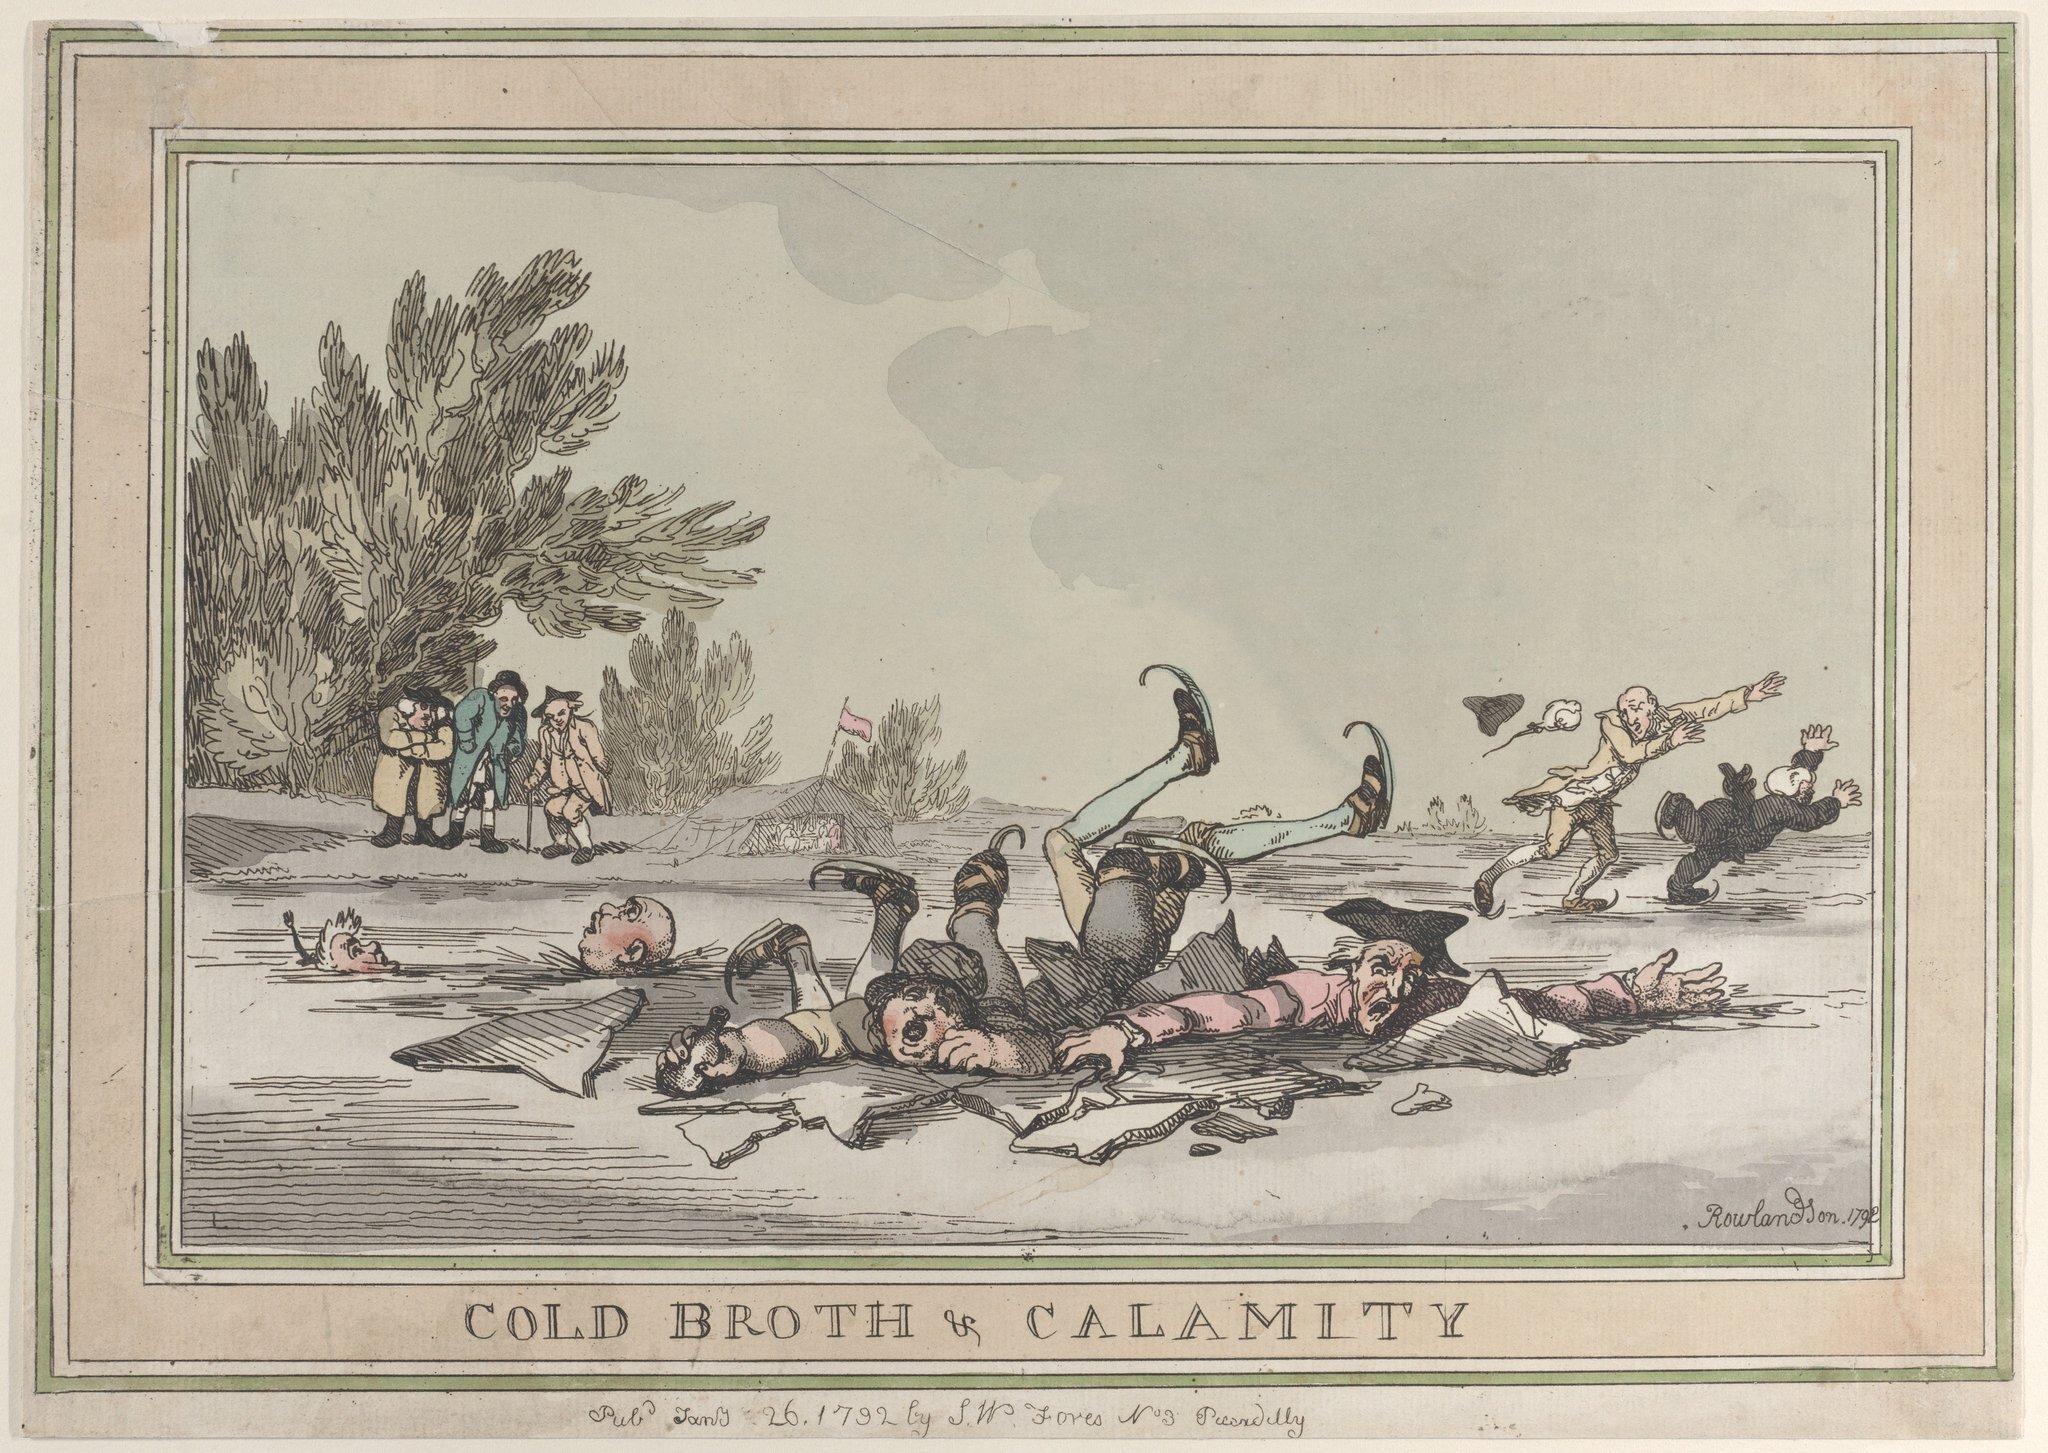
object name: print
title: Cold Broth & Calamity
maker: thomas rowlandson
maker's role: artist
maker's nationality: british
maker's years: 1757-1827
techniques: etching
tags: satire,men,skating